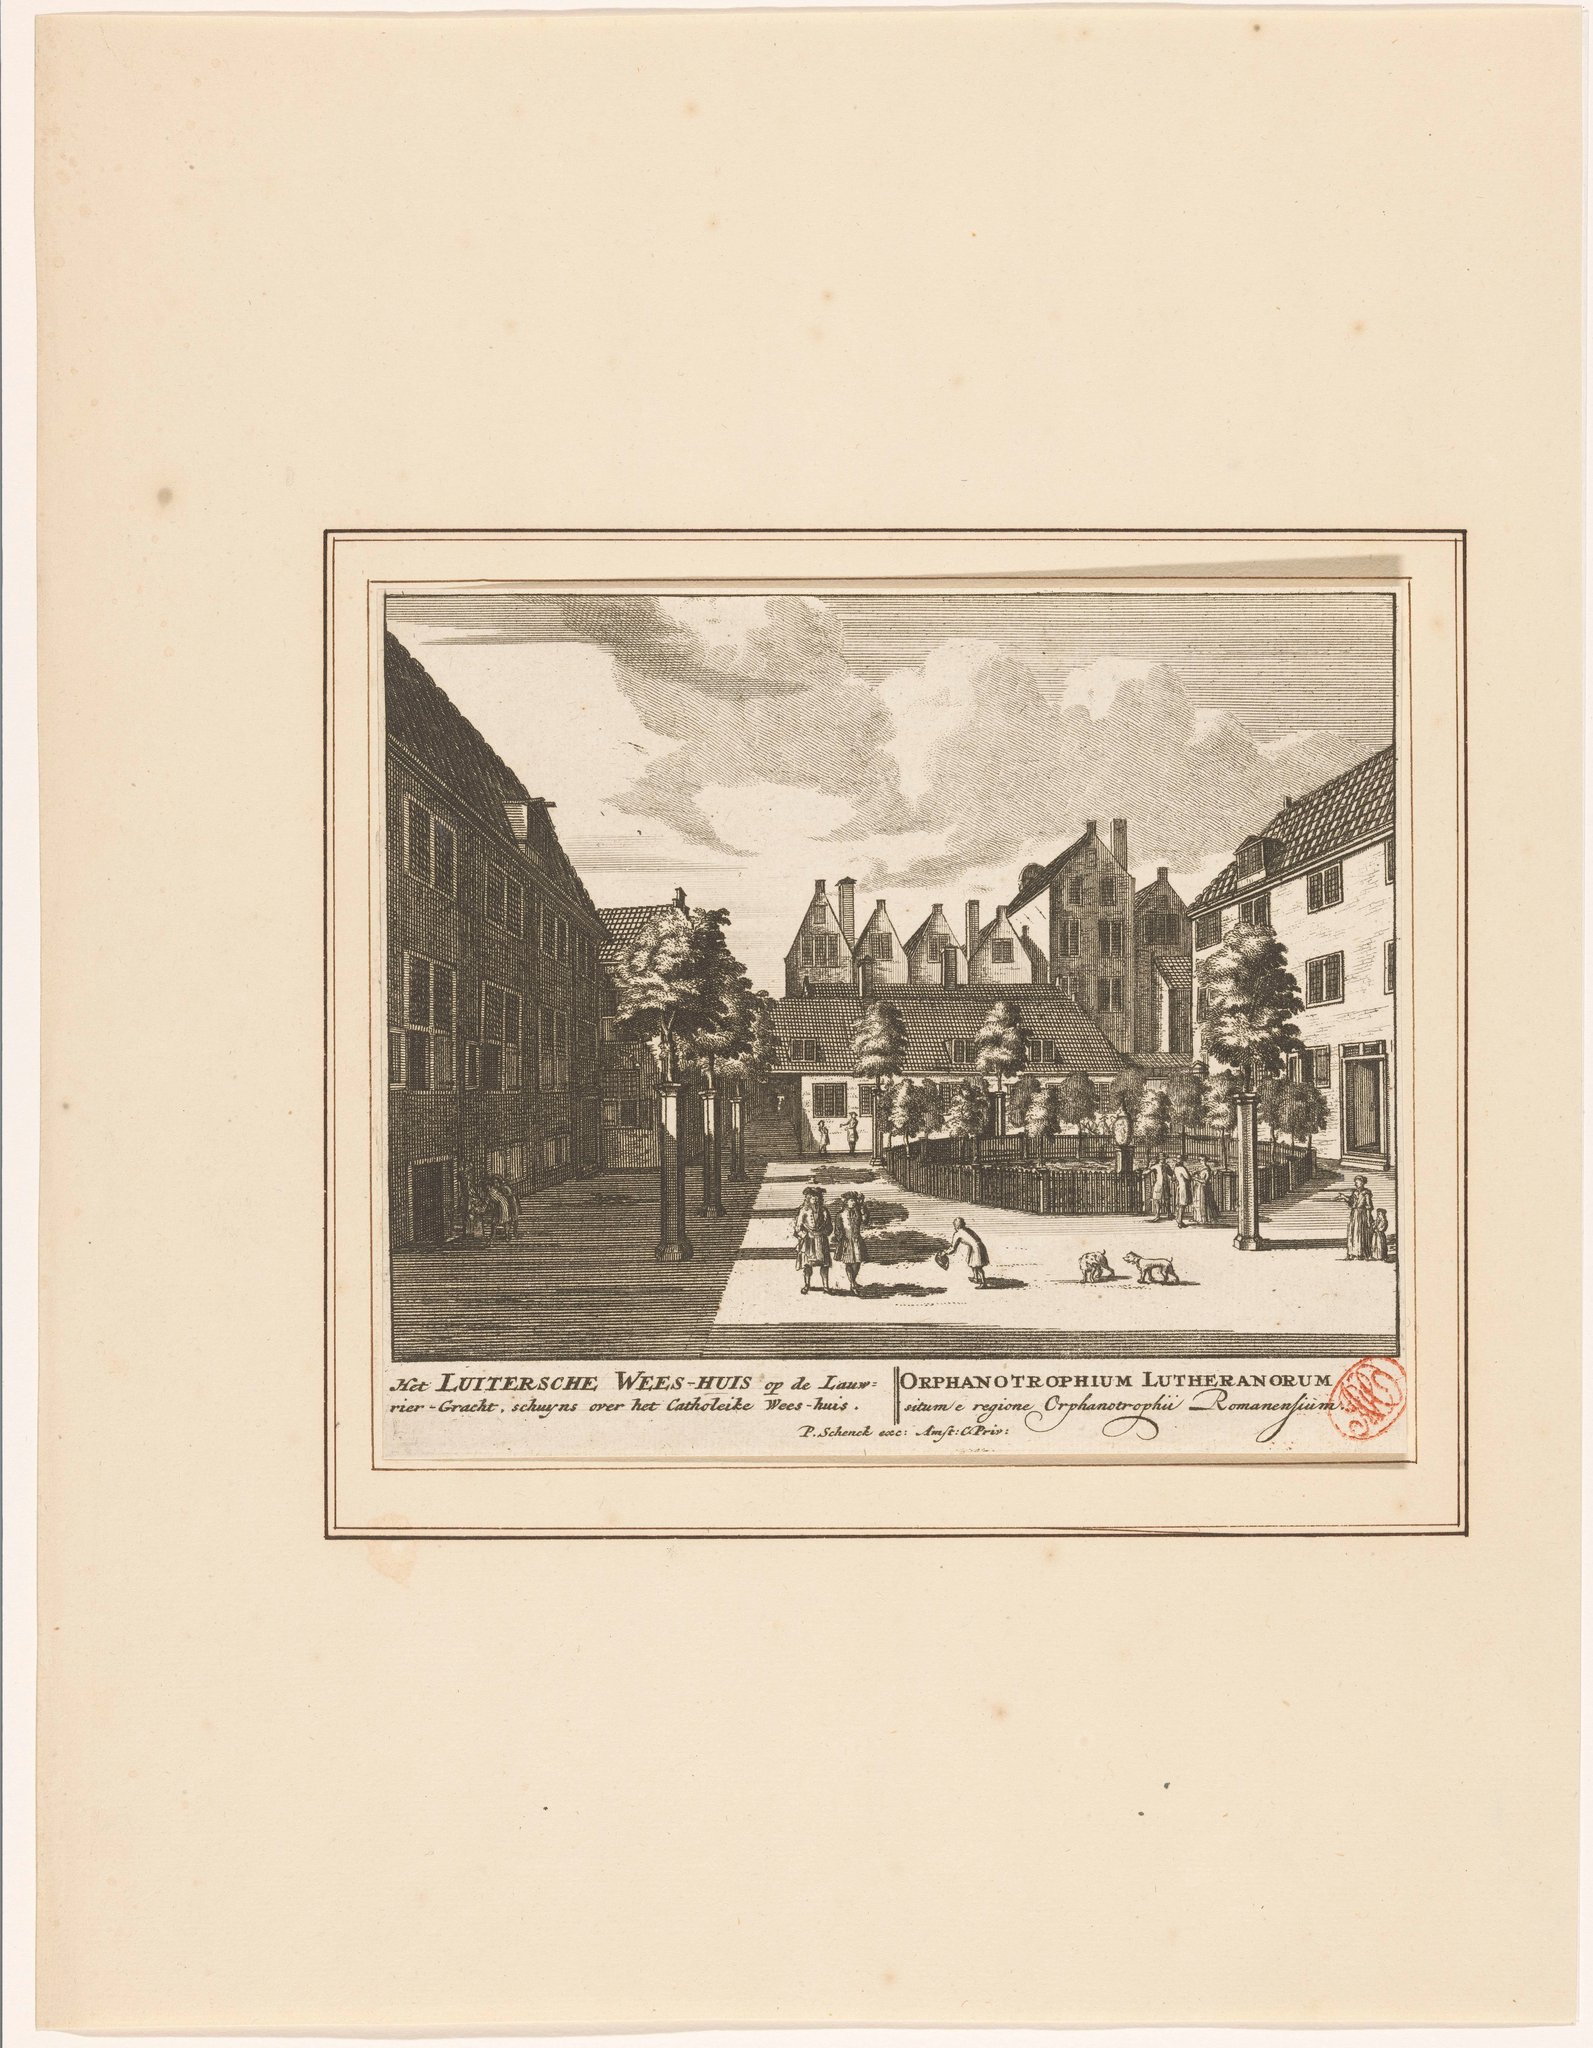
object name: print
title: Gezicht op de binnenplaats van het Lutherse Diaconieweeshuis te Amsterdam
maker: Anonymous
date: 1710-1711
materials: paper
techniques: engraving, etching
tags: public welfare, courtyard, orphanage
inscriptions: collector's mark: Lugt 195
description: Genummerde staat van prent ook gebruikt in: 100 Afbeeldinge der voornaamste gebouwen van Amsterdam. Amsterdam, Pieter Schenk (I), s.a. [1710-1711]. En in: 100 Afbeeldinge der voornaamste gebouwen van Amsterdam. Amsterdam, Barent Greve, s.a. [1757-1766].* *In de tweede uitgave, uitgegeven door Barent Greve, is alleen de titelprent aangepast. De overige prenten zijn onveranderd gebleven.